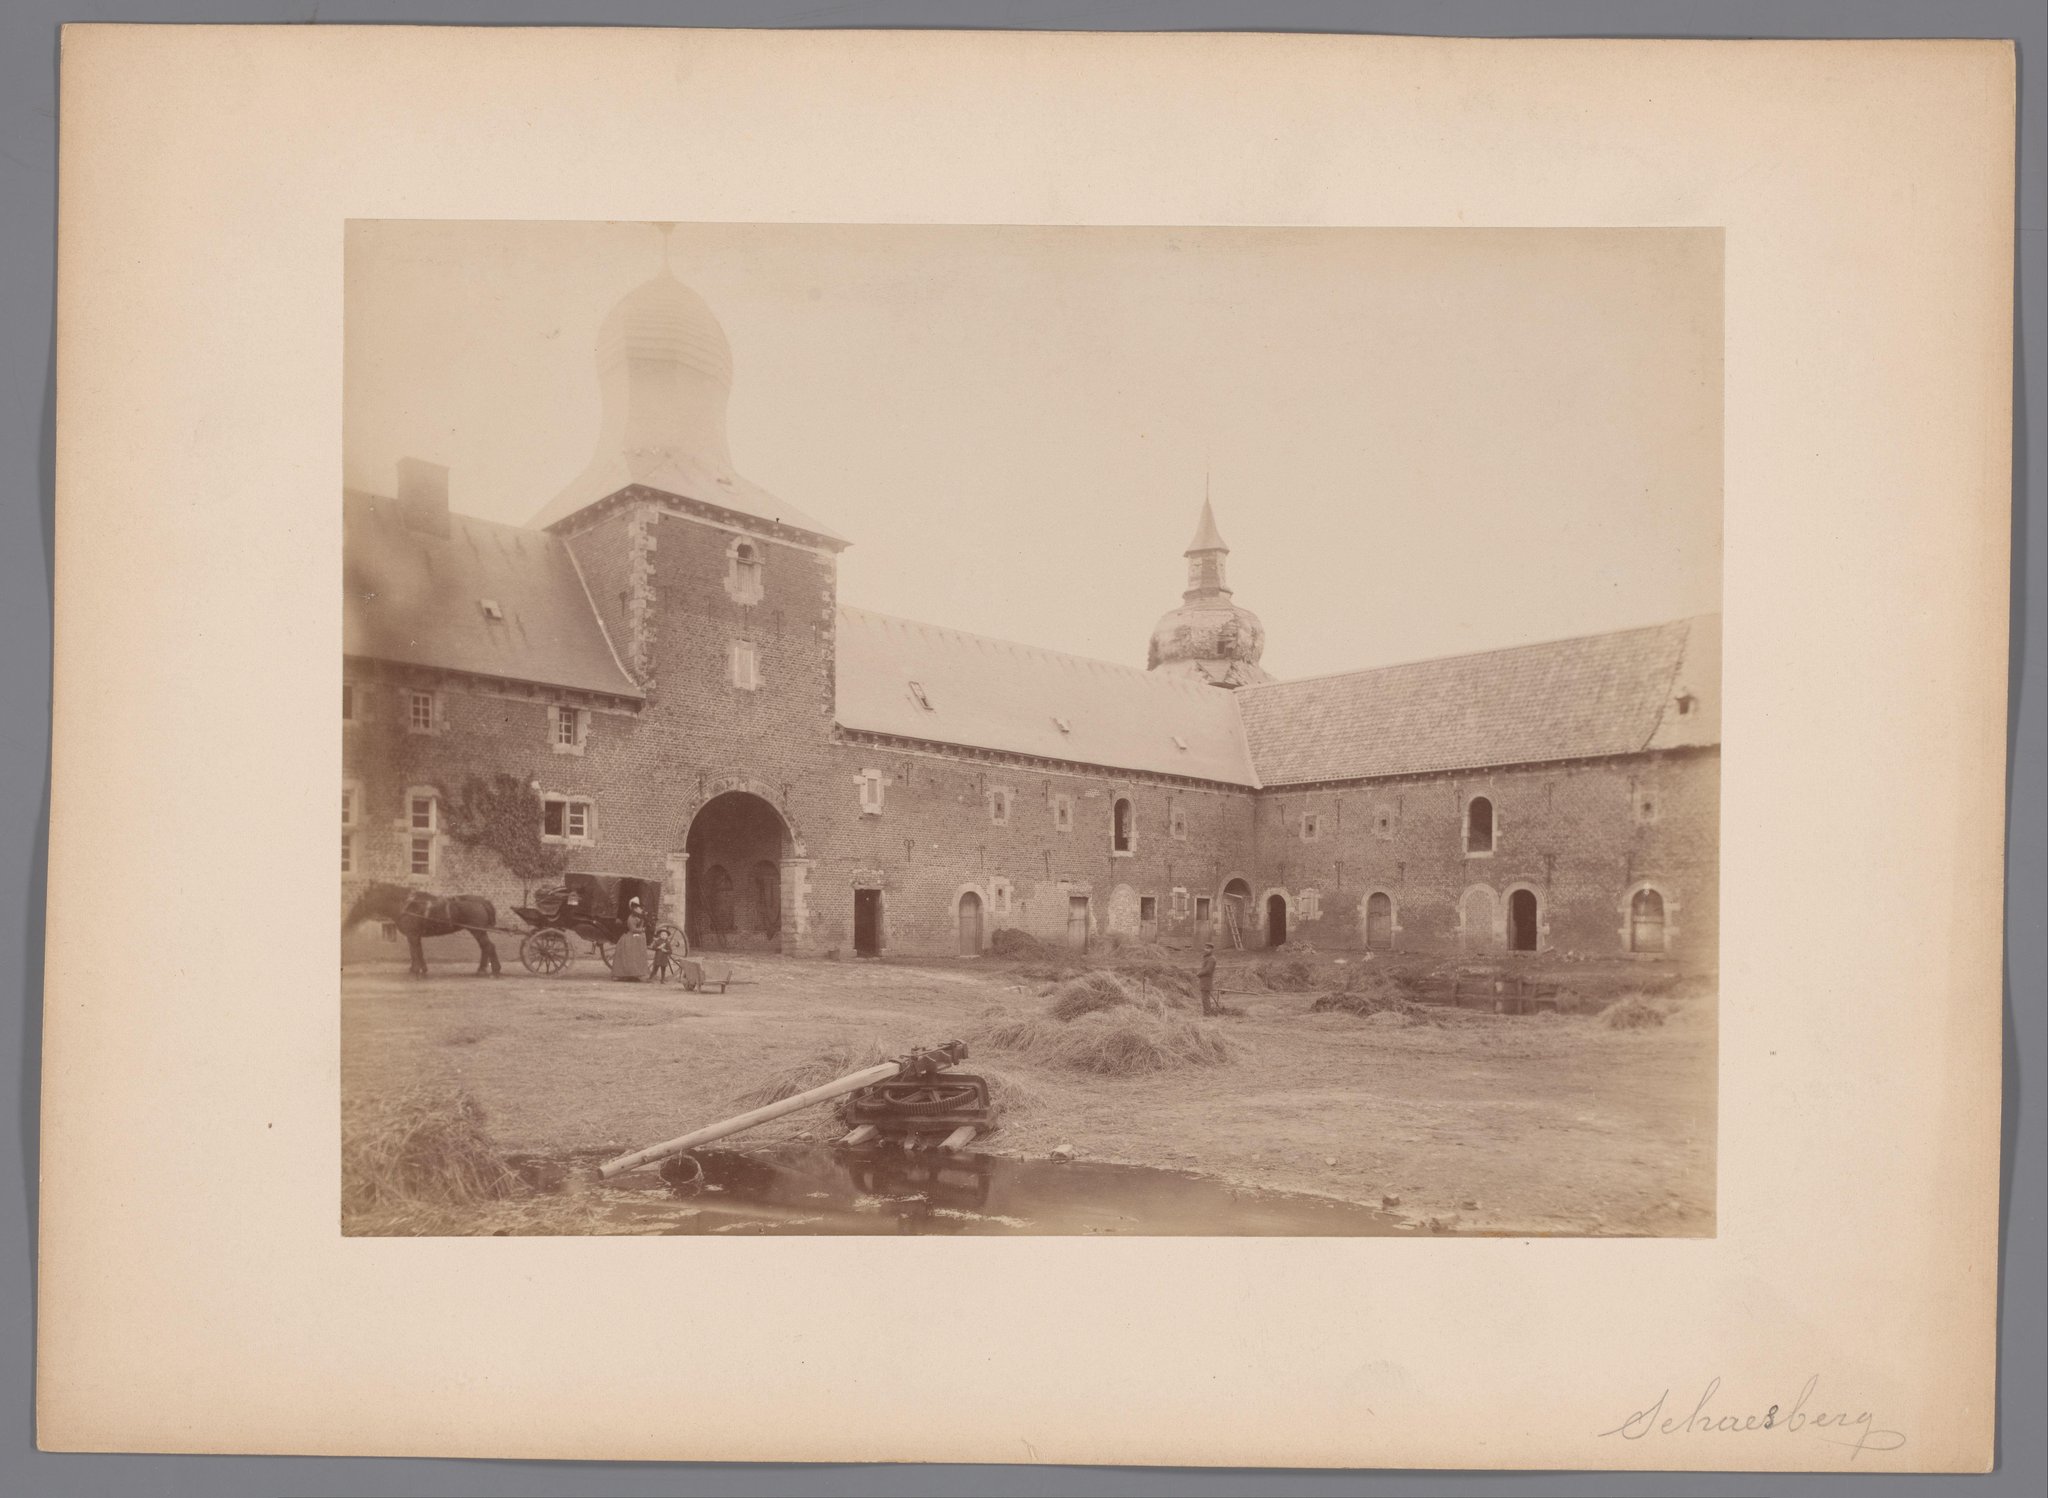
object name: photograph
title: Binnenplaats van de boerderij bij Kasteel Schaesberg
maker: anoniem (monumentenzorg)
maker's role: fotograaf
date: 1890-1920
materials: cardboard, photographic support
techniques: albumen print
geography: schaesberg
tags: castle, courtyard, farm (building)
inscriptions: annotation: ‘Schaesberg Boerderij/ Binnenplaats’, annotation: ‘Schaesberg’